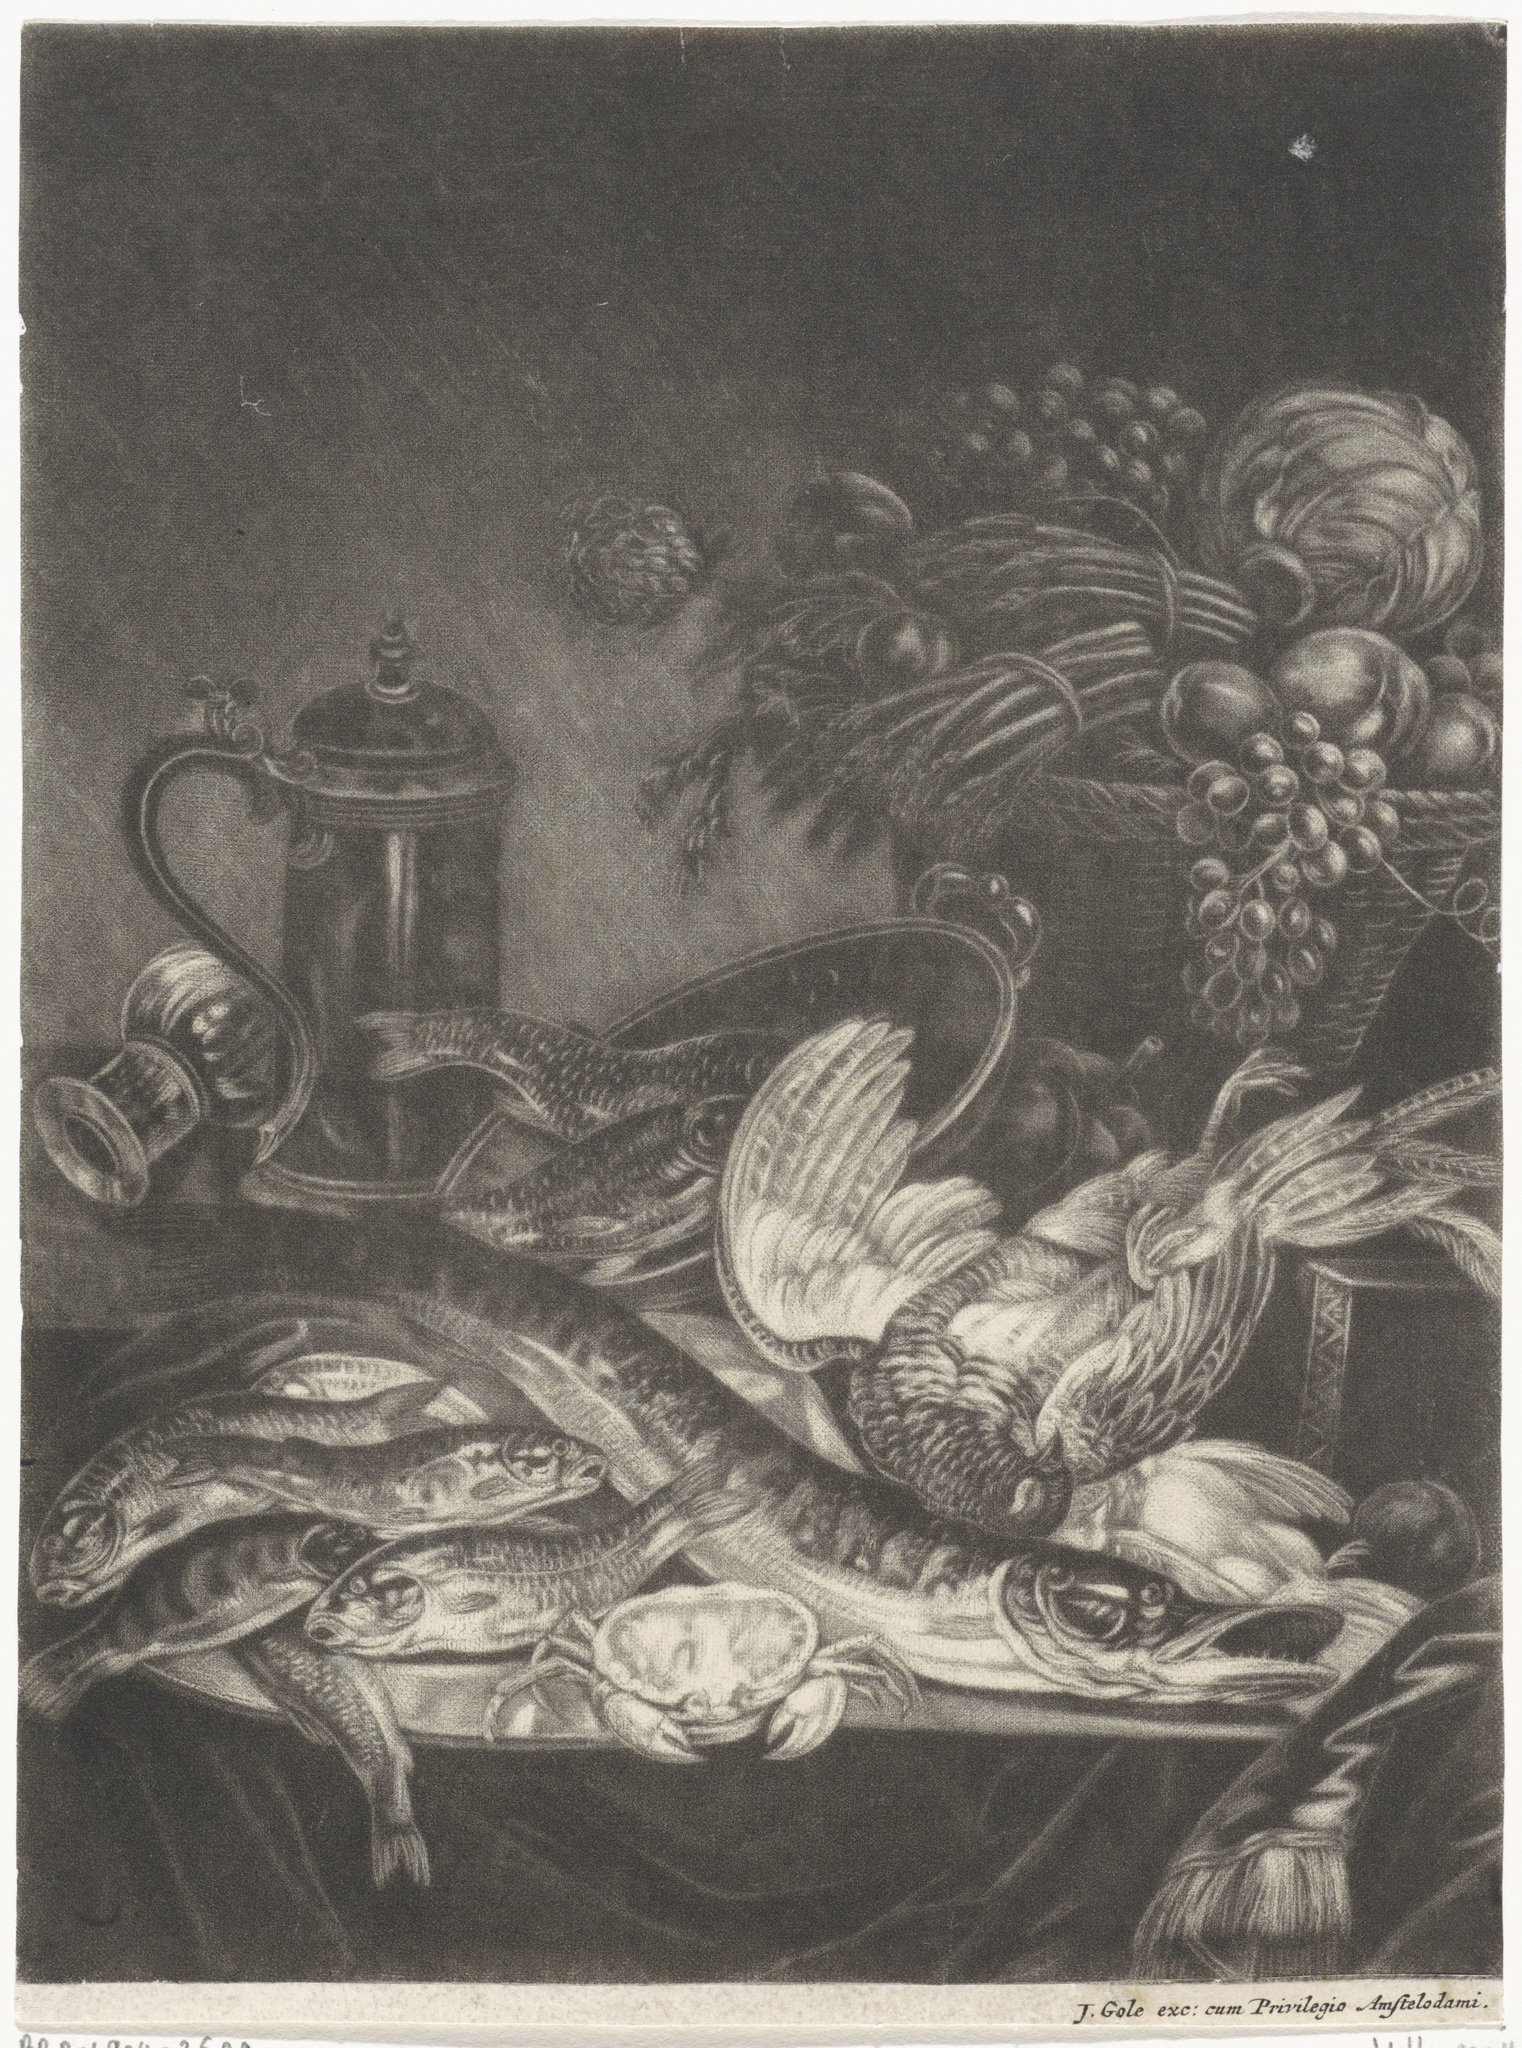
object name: print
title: Stilleven met vissen, gevogelte, groente en fruit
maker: jacob gole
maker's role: print maker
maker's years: 1660-1724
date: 1670-1724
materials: paper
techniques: engraving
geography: amsterdam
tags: birds, fishes, crustaceans: crab, fish; still life of fishes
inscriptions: collector's mark: Lugt 2228